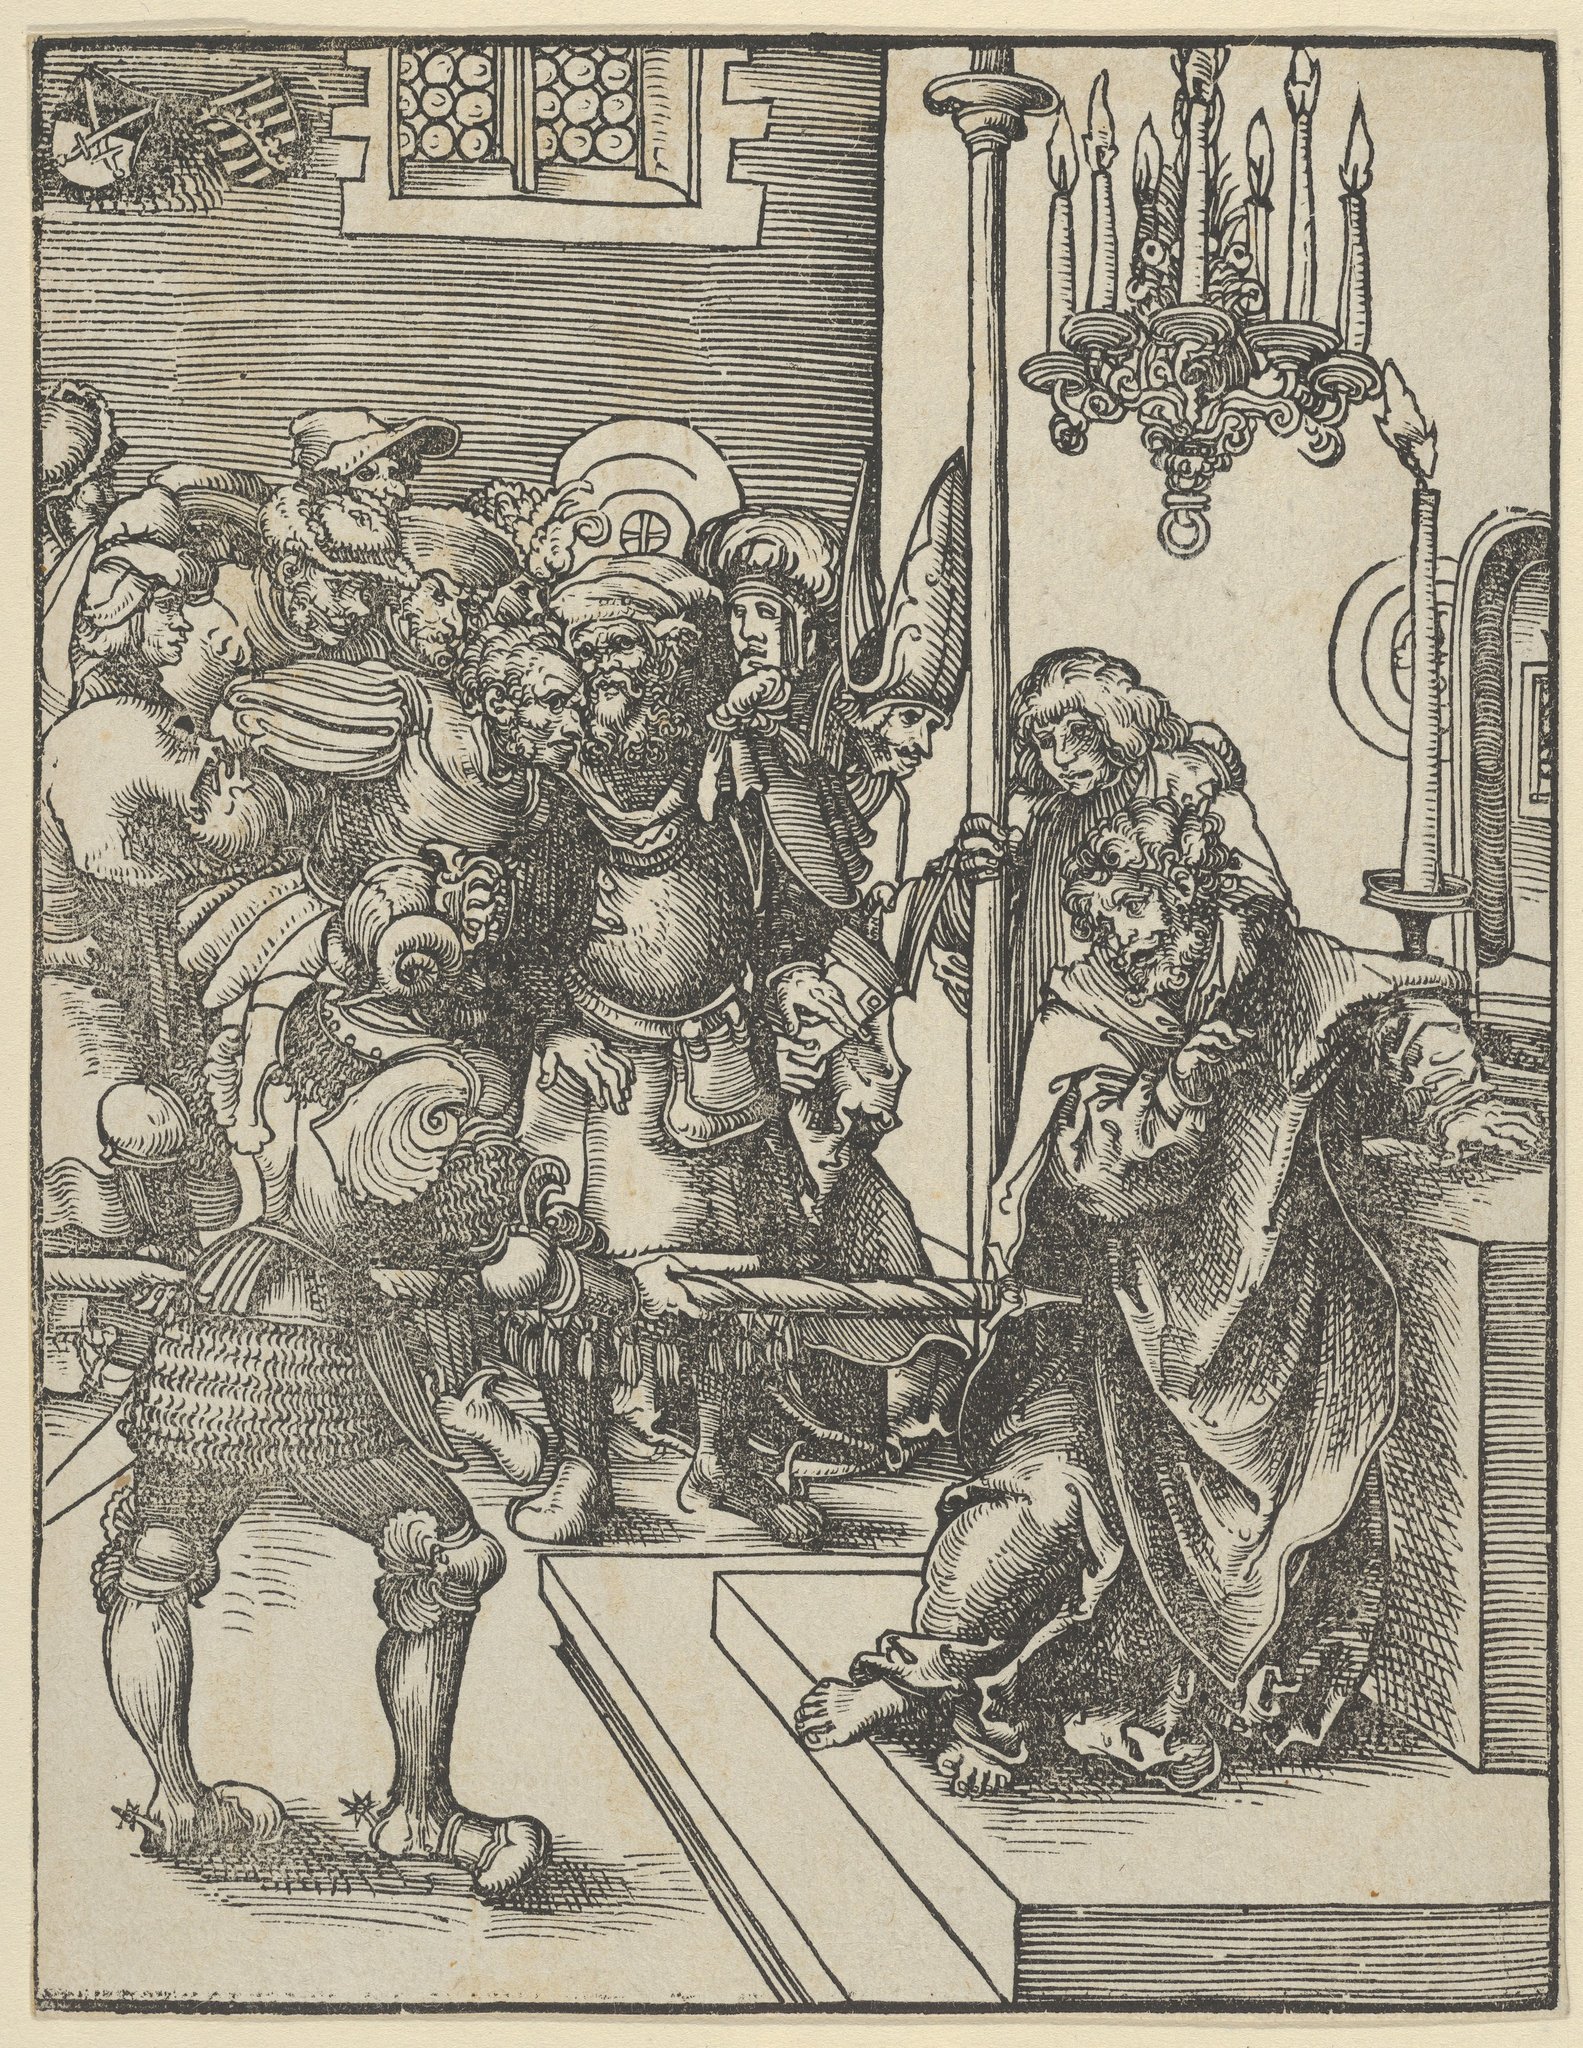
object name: print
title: Thomas from the Martyrdom of the Twelve Apostles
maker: lucas cranach the elder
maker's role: artist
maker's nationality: german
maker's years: 1472-1553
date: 1472-1553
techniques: woodcut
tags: apostles